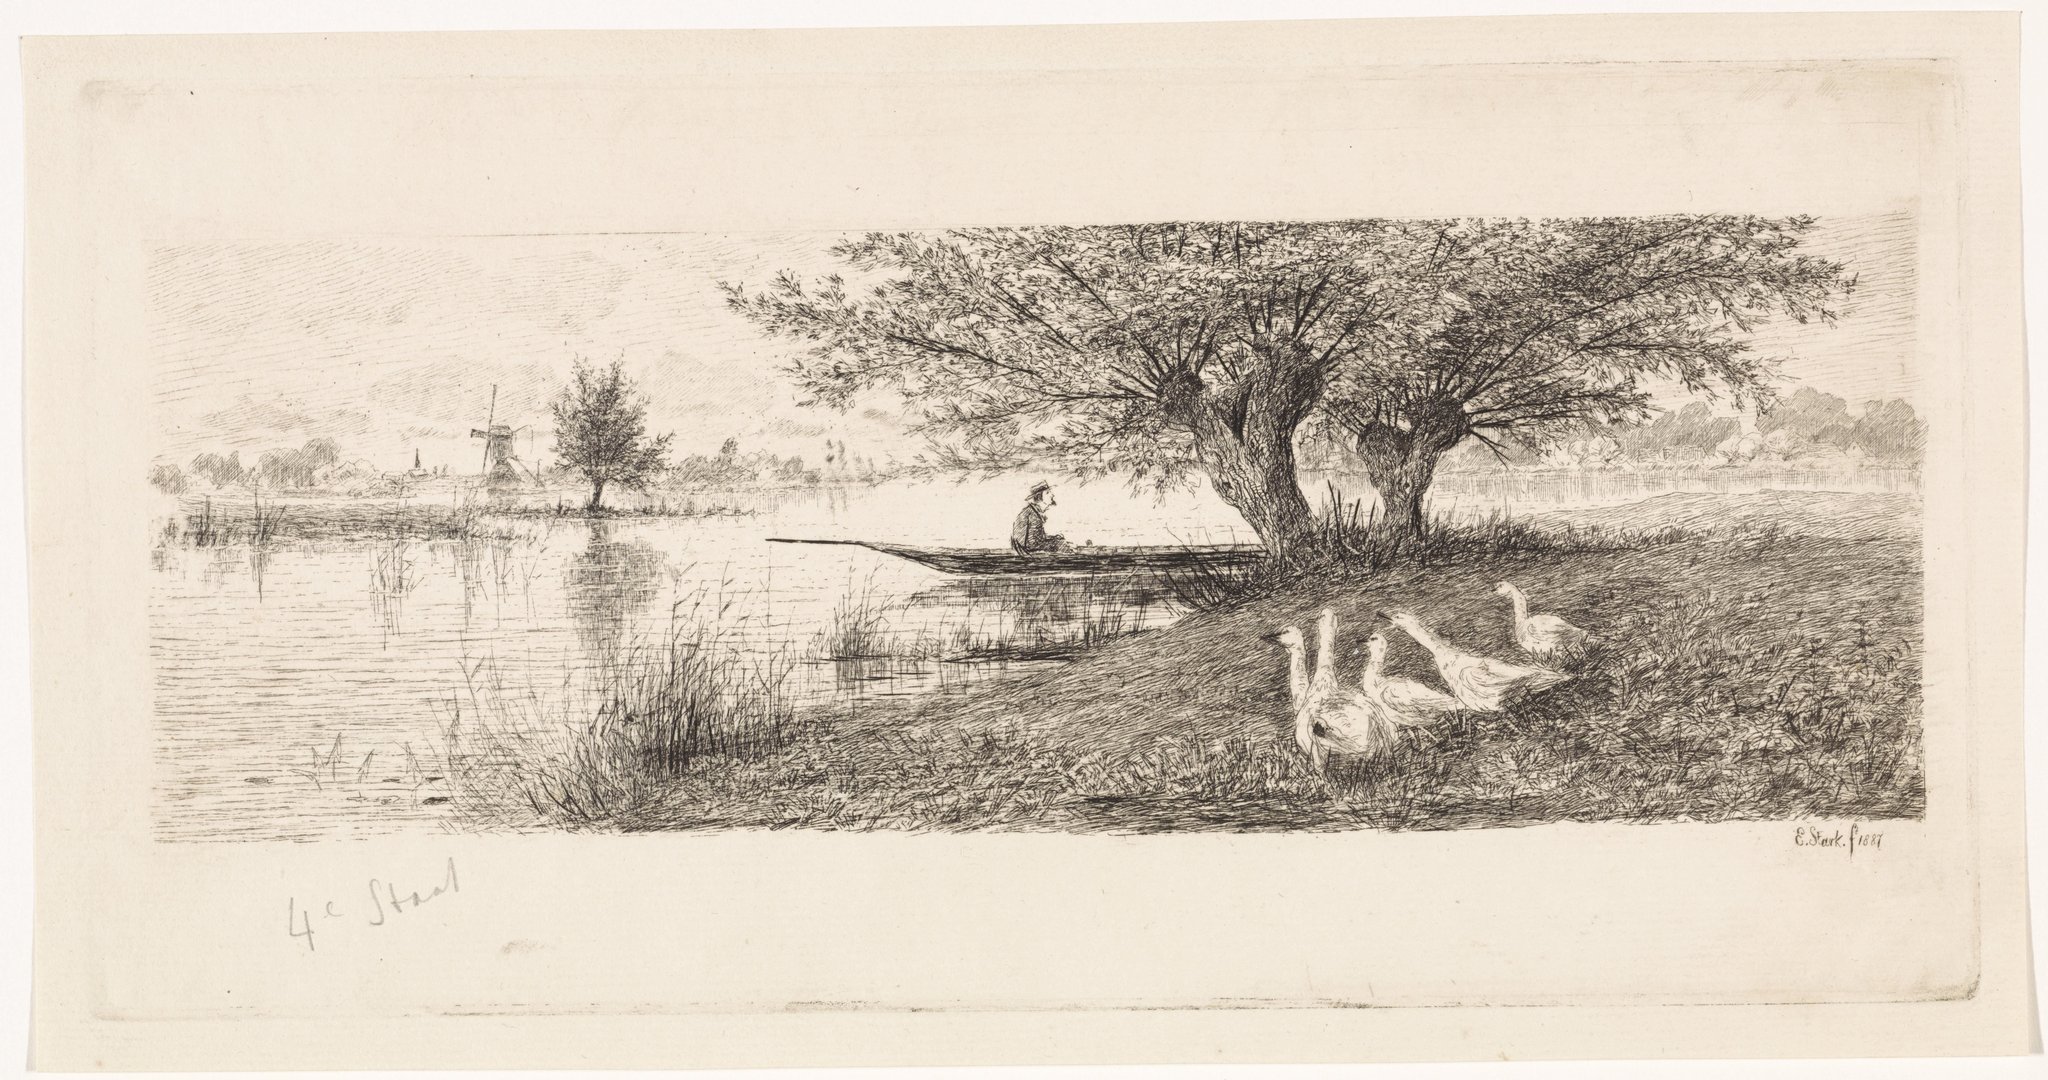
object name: print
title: Rivierlandschap met een man in een boot en ganzen op de oever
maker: elias stark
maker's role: draughtsman, print maker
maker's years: 1849-1933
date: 1887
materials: paper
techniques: etching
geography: nieuwer-amstel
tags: water-birds: goose, river, rowing-boat, canoe, etc., trees: willow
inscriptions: collector's mark: Lugt 2228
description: Op een rivier een man in een boot bij twee knotwilgen. Rechts op de oever ganzen. Links aan de horizon een molen.